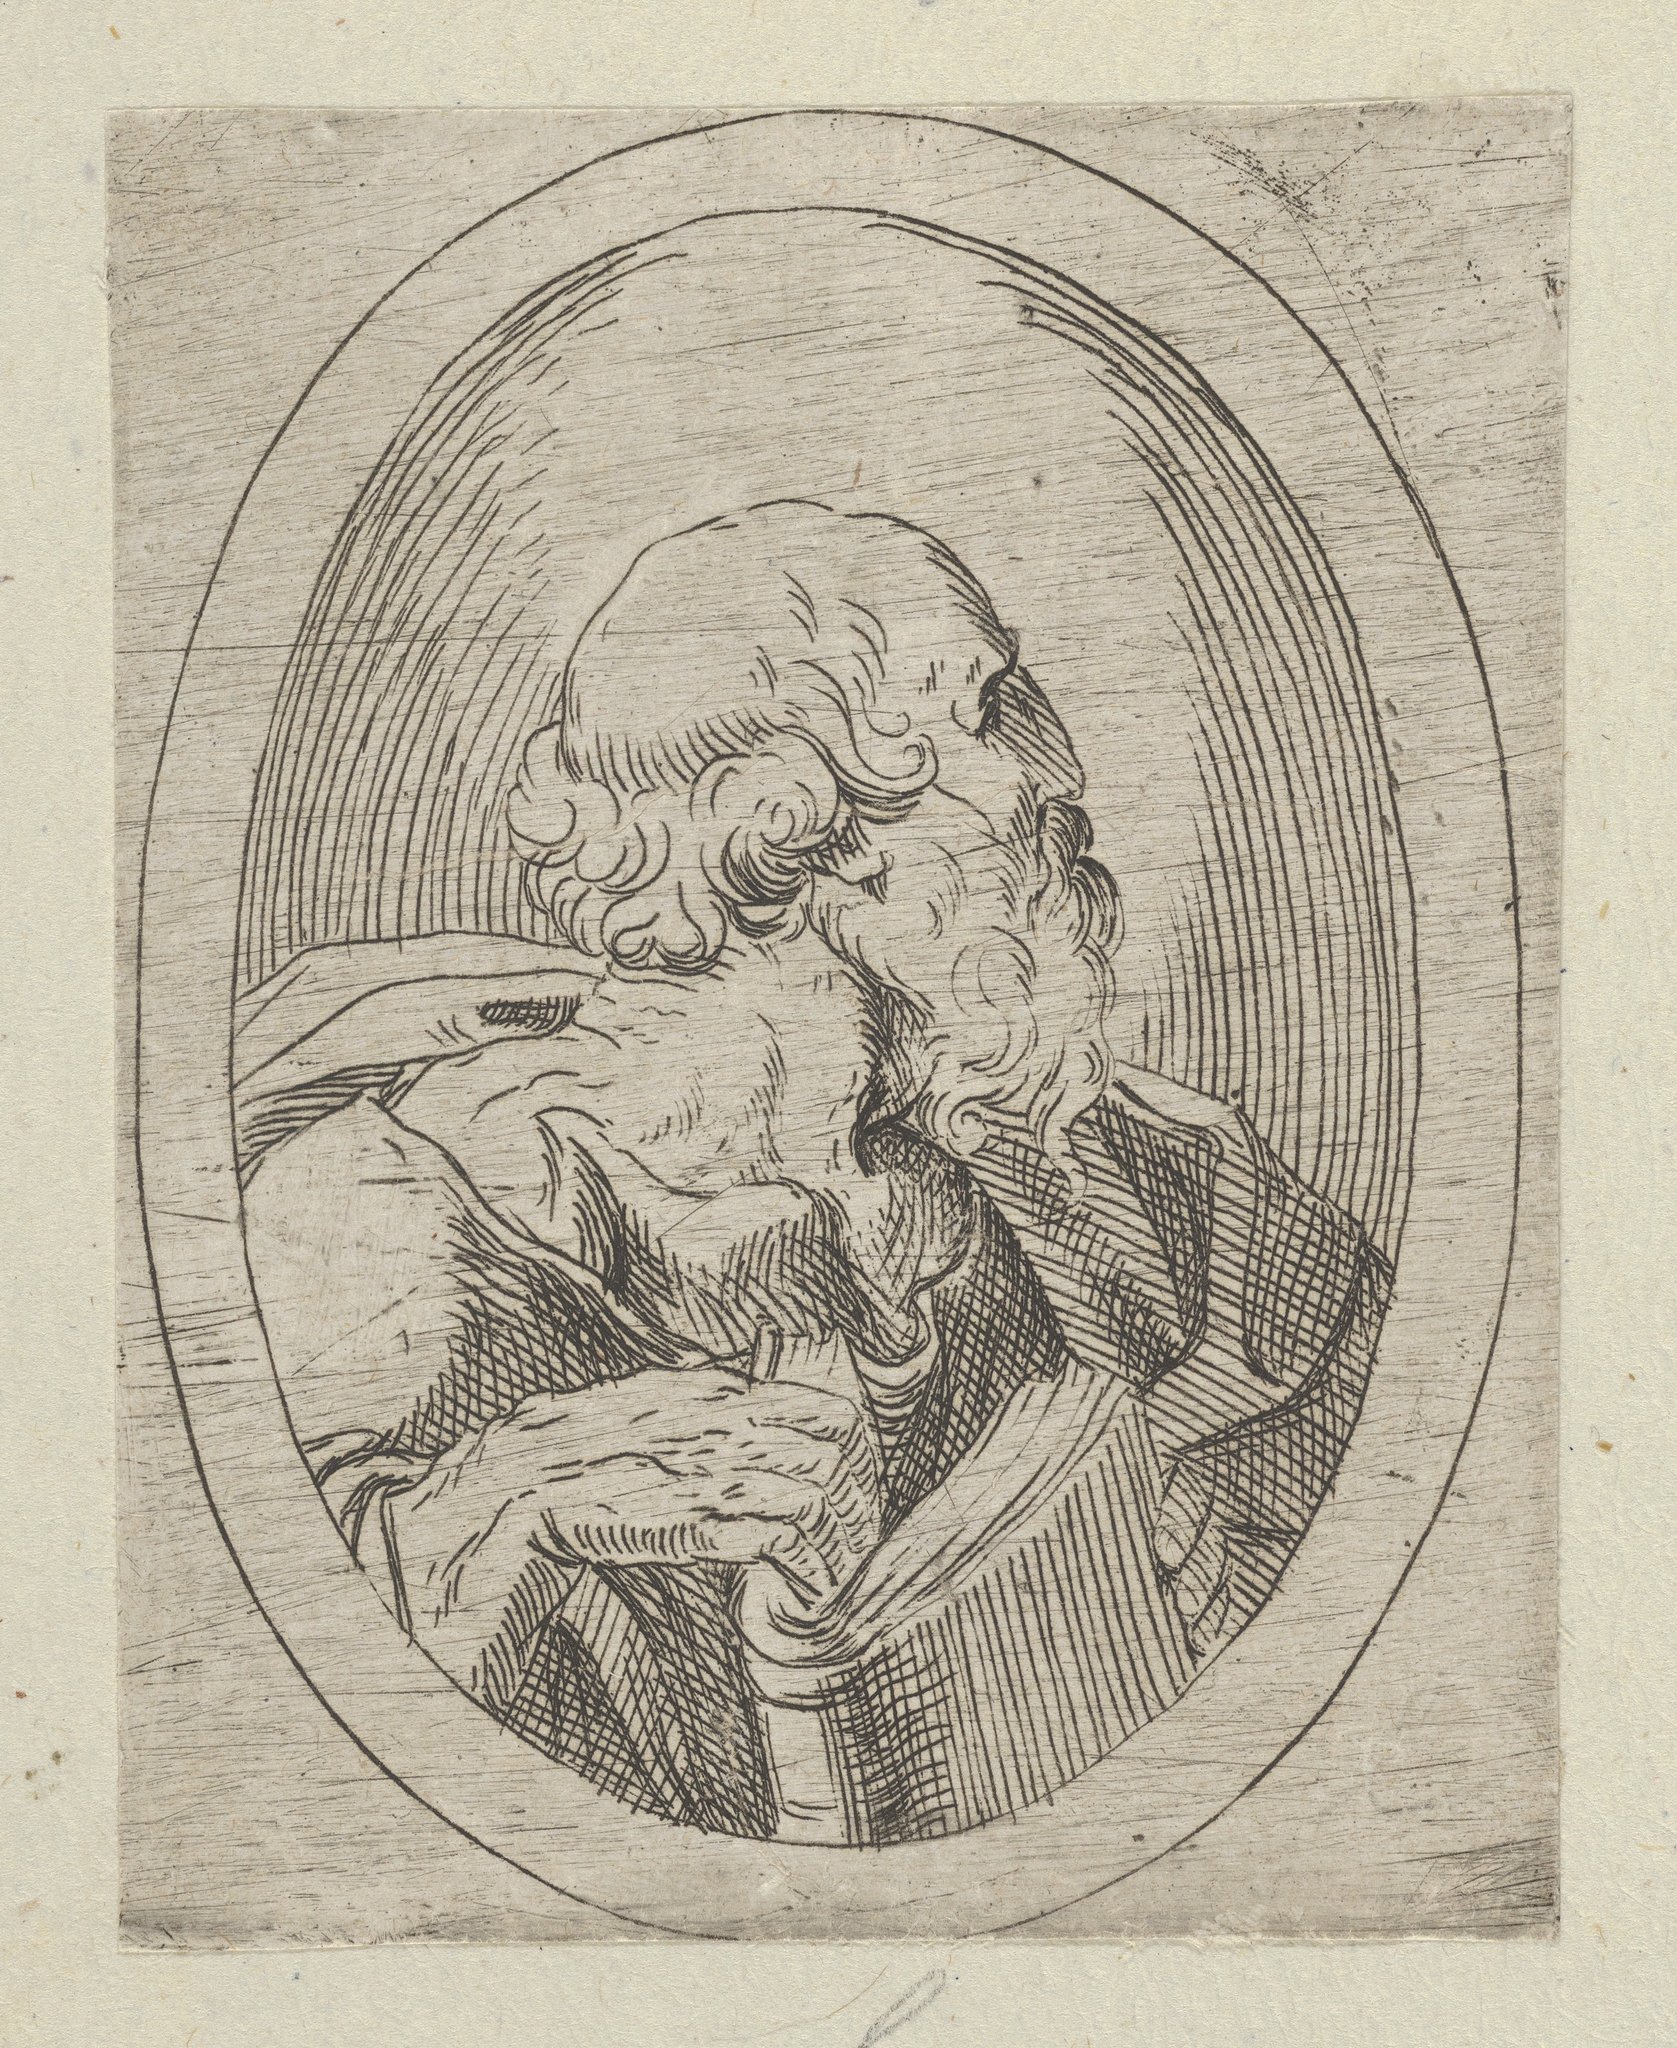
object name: print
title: An apostle seen in profile facing right, holding an open book, in an oval frame, from "Christ, the Virgin, and Thirteen Apostles"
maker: anonymous, 17th century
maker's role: artist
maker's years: 1600-1700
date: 1600-1640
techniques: etching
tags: profiles,apostles